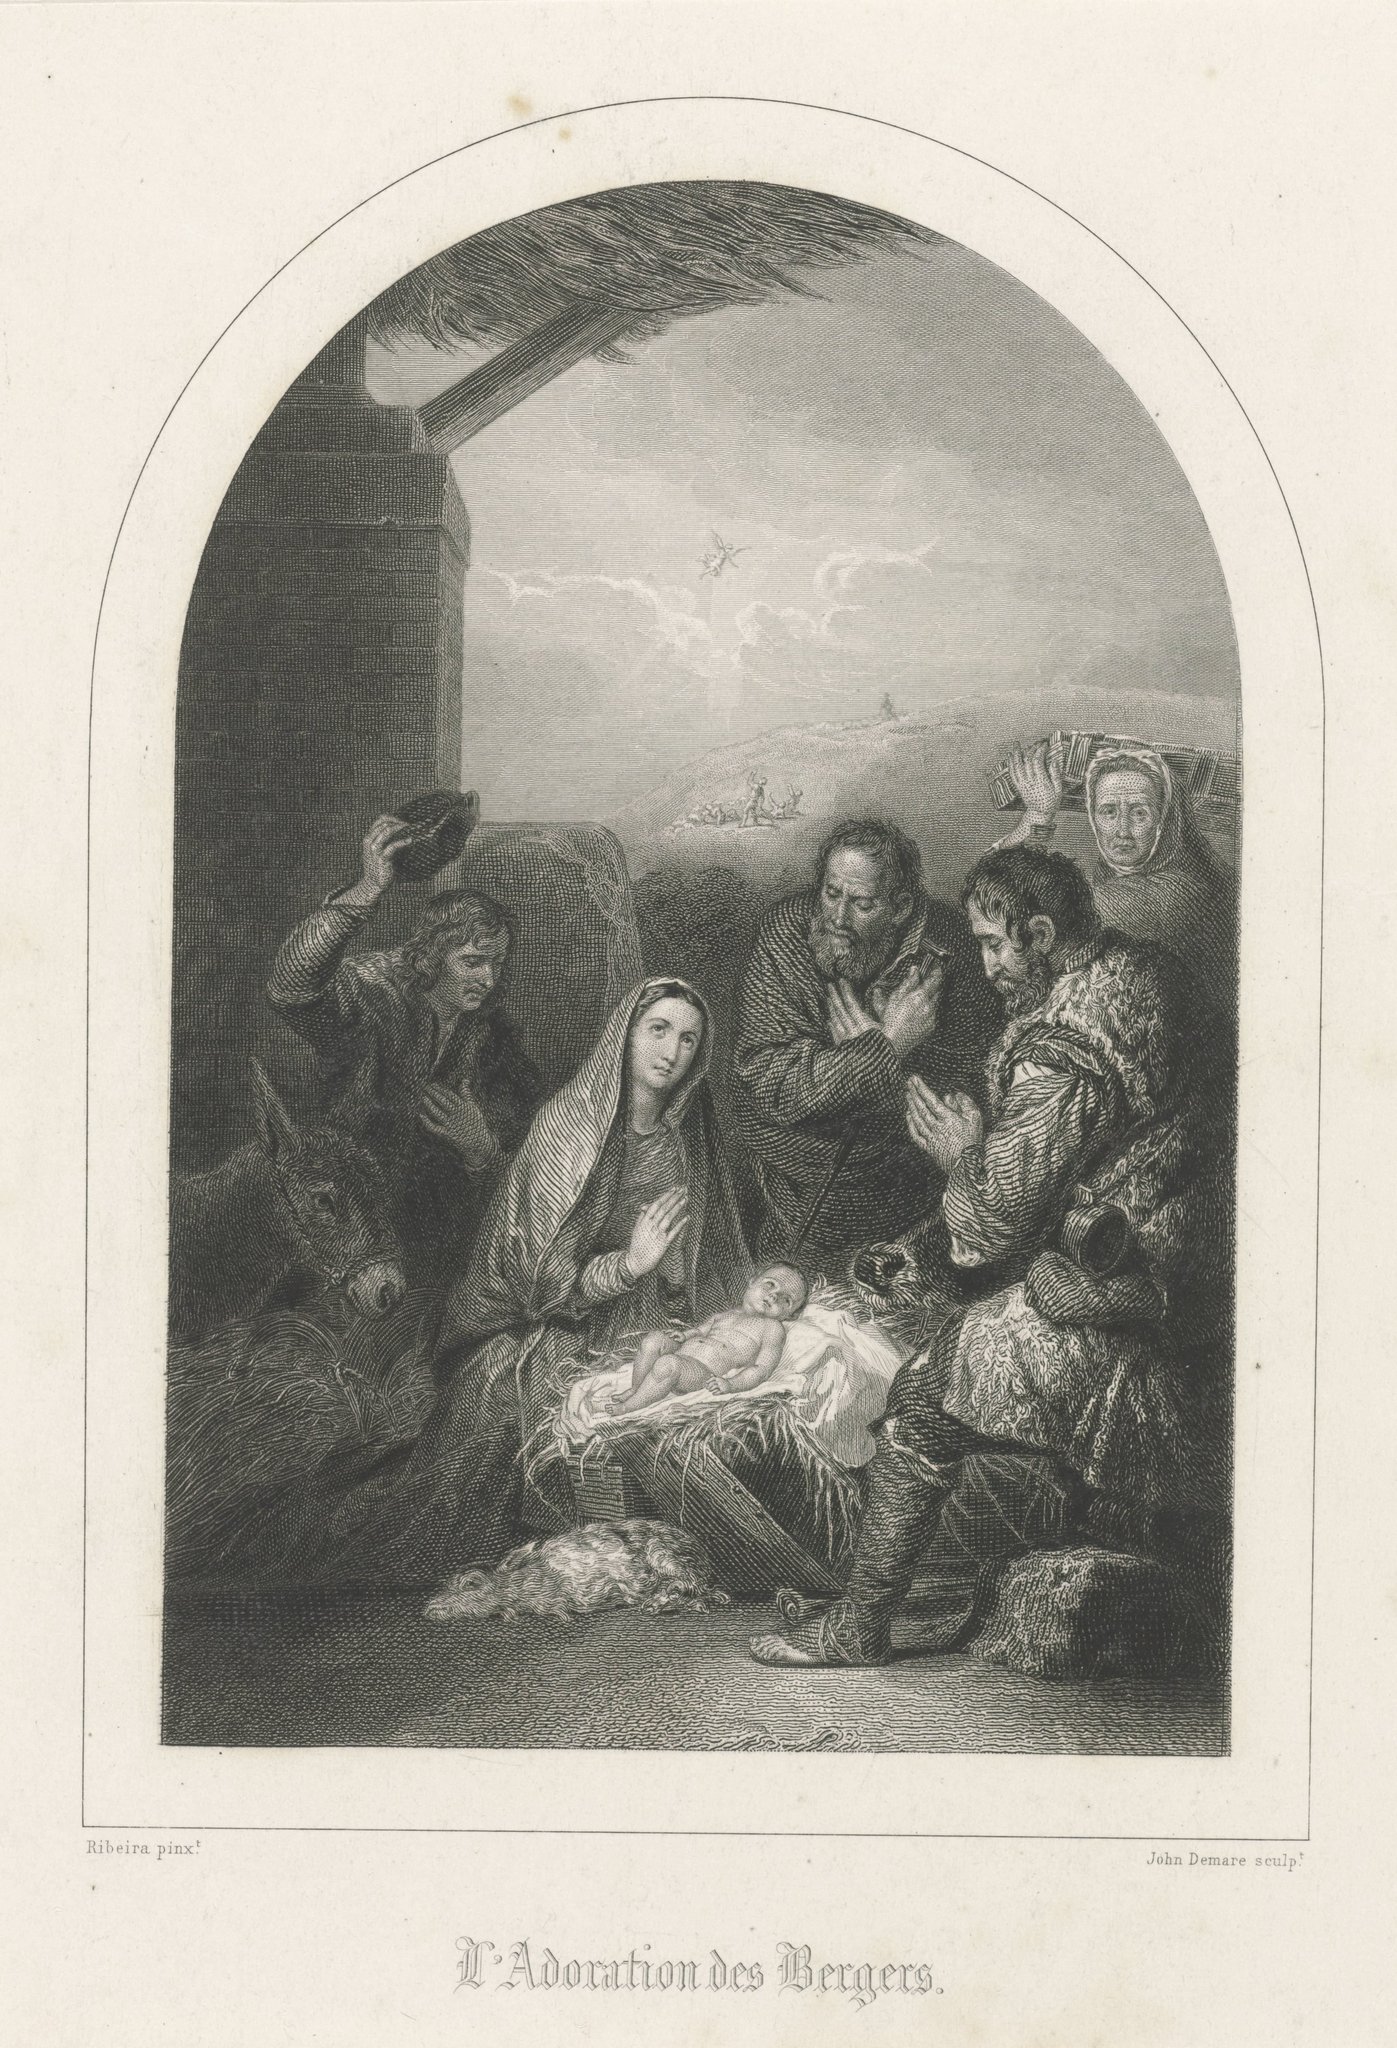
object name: print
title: L'Adoration des Bergers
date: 1816-1889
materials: paper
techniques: engraving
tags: adoration of the christ-child by the shepherds; mary and joseph present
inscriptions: collector's mark: Lugt 2228